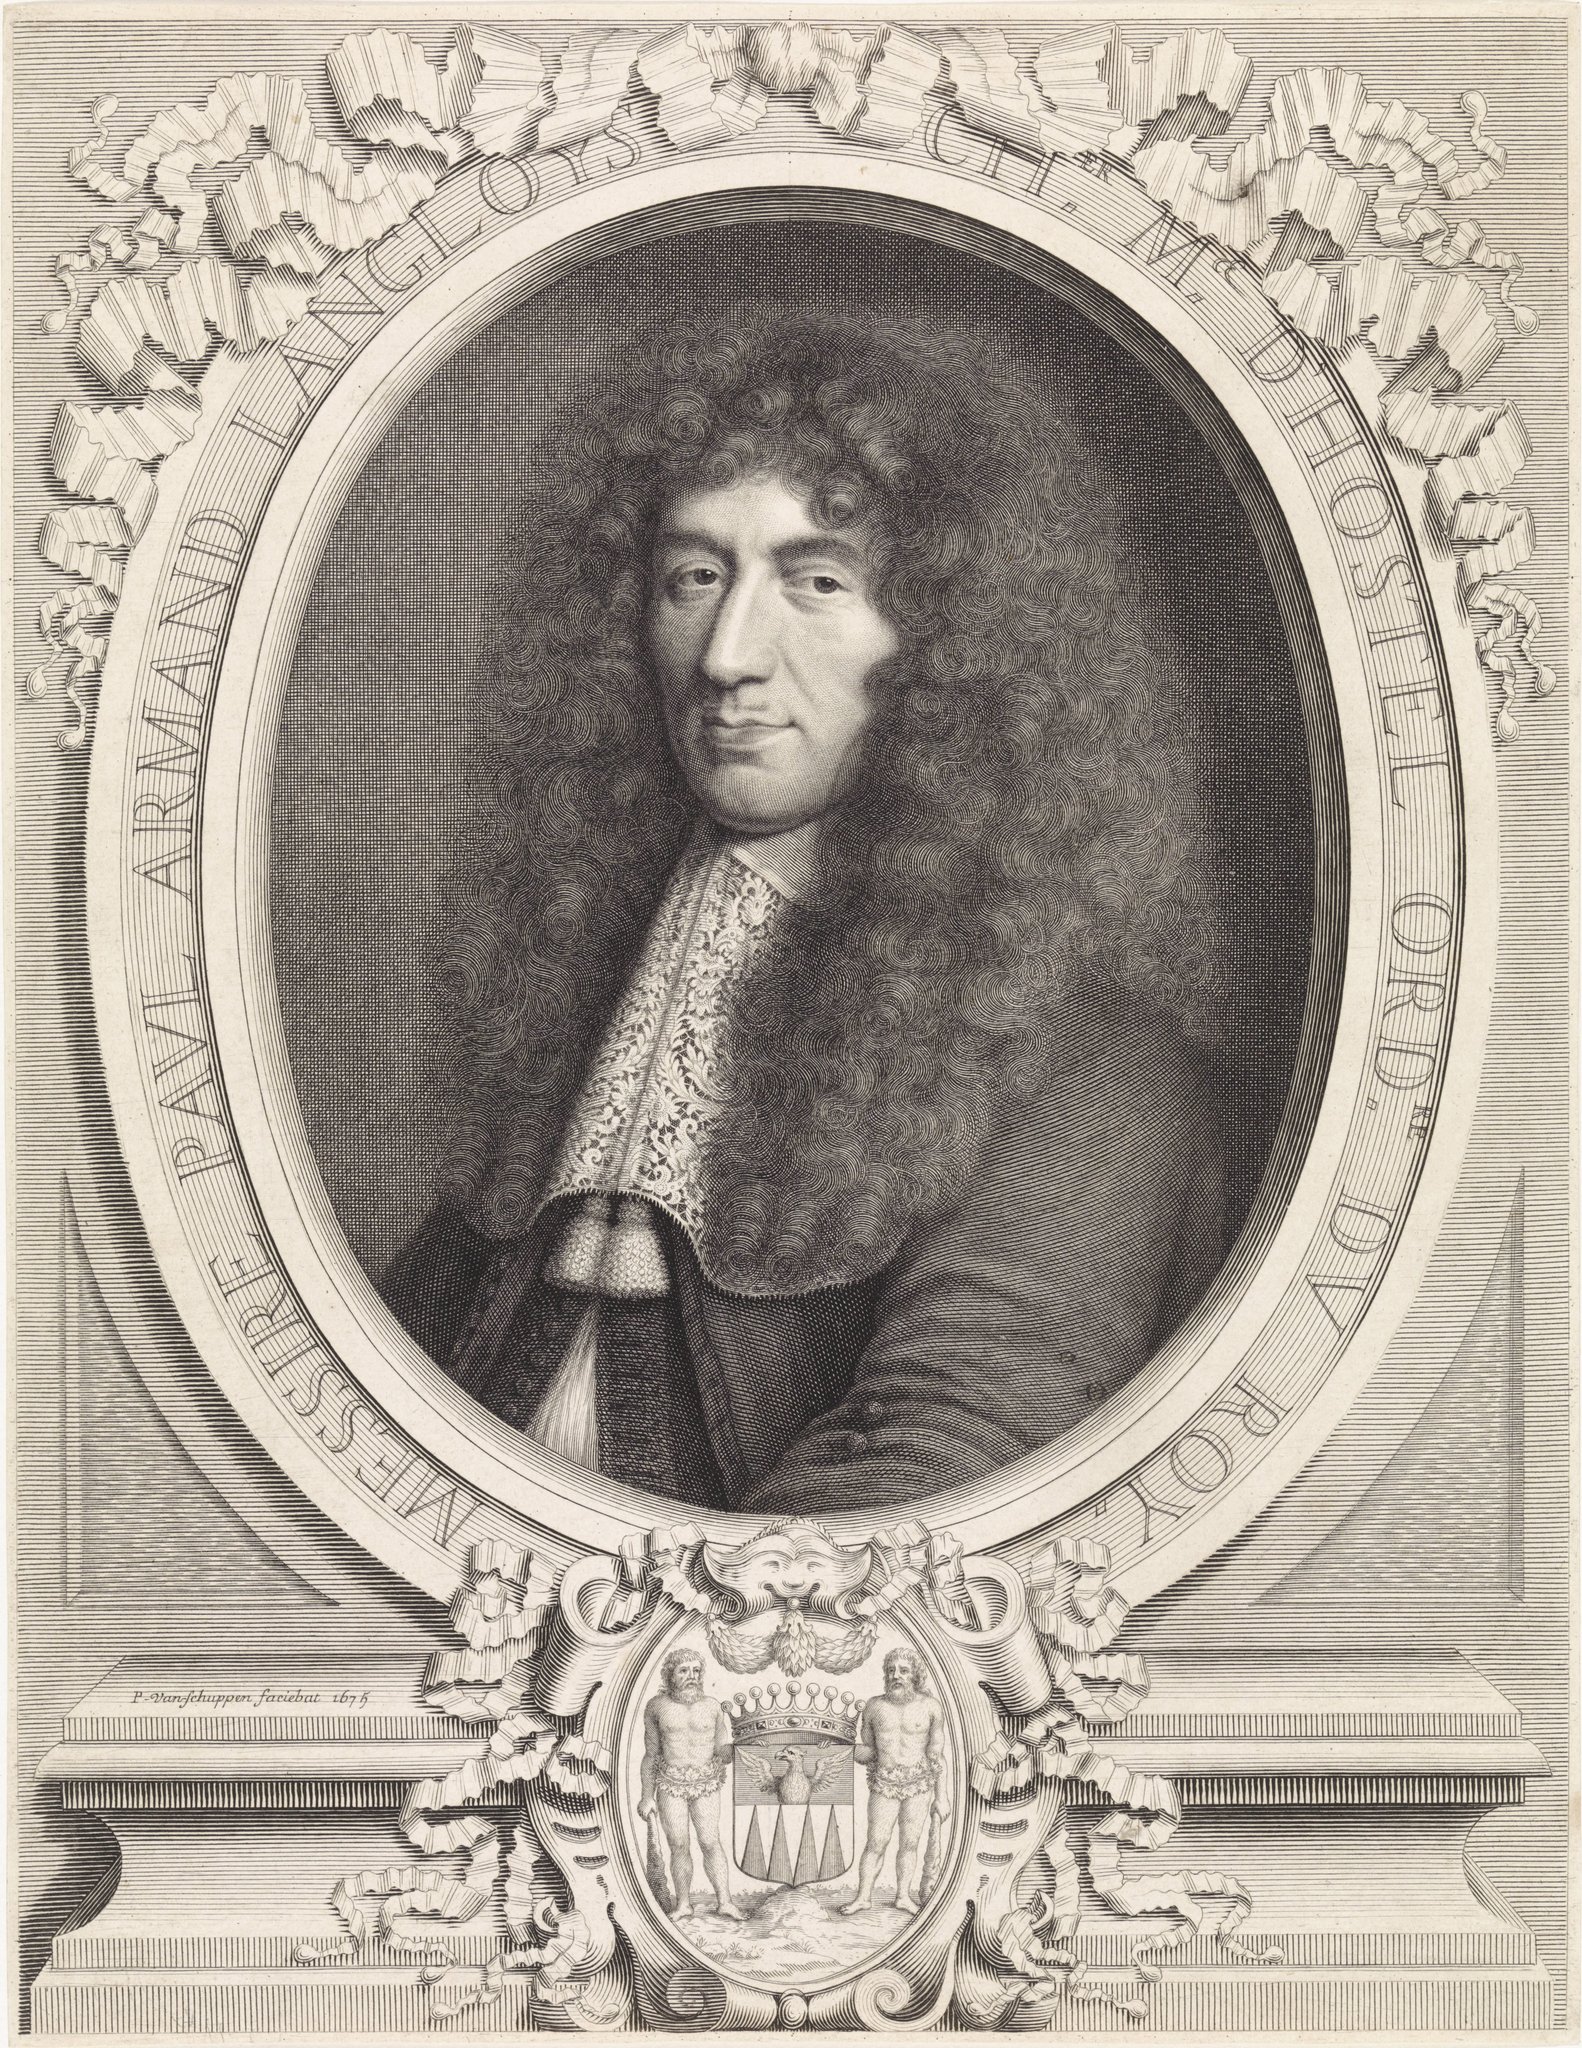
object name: print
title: Portret van Paul-Armand Langlois de Blancfort, maître d'hôtel van Lodewijk XIV, koning van Frankrijk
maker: pieter van schuppen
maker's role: print maker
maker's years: 1627-1702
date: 1675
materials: paper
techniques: engraving, etching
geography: paris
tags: paul-armand langlois de blancfort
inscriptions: collector's mark: Lugt 2228